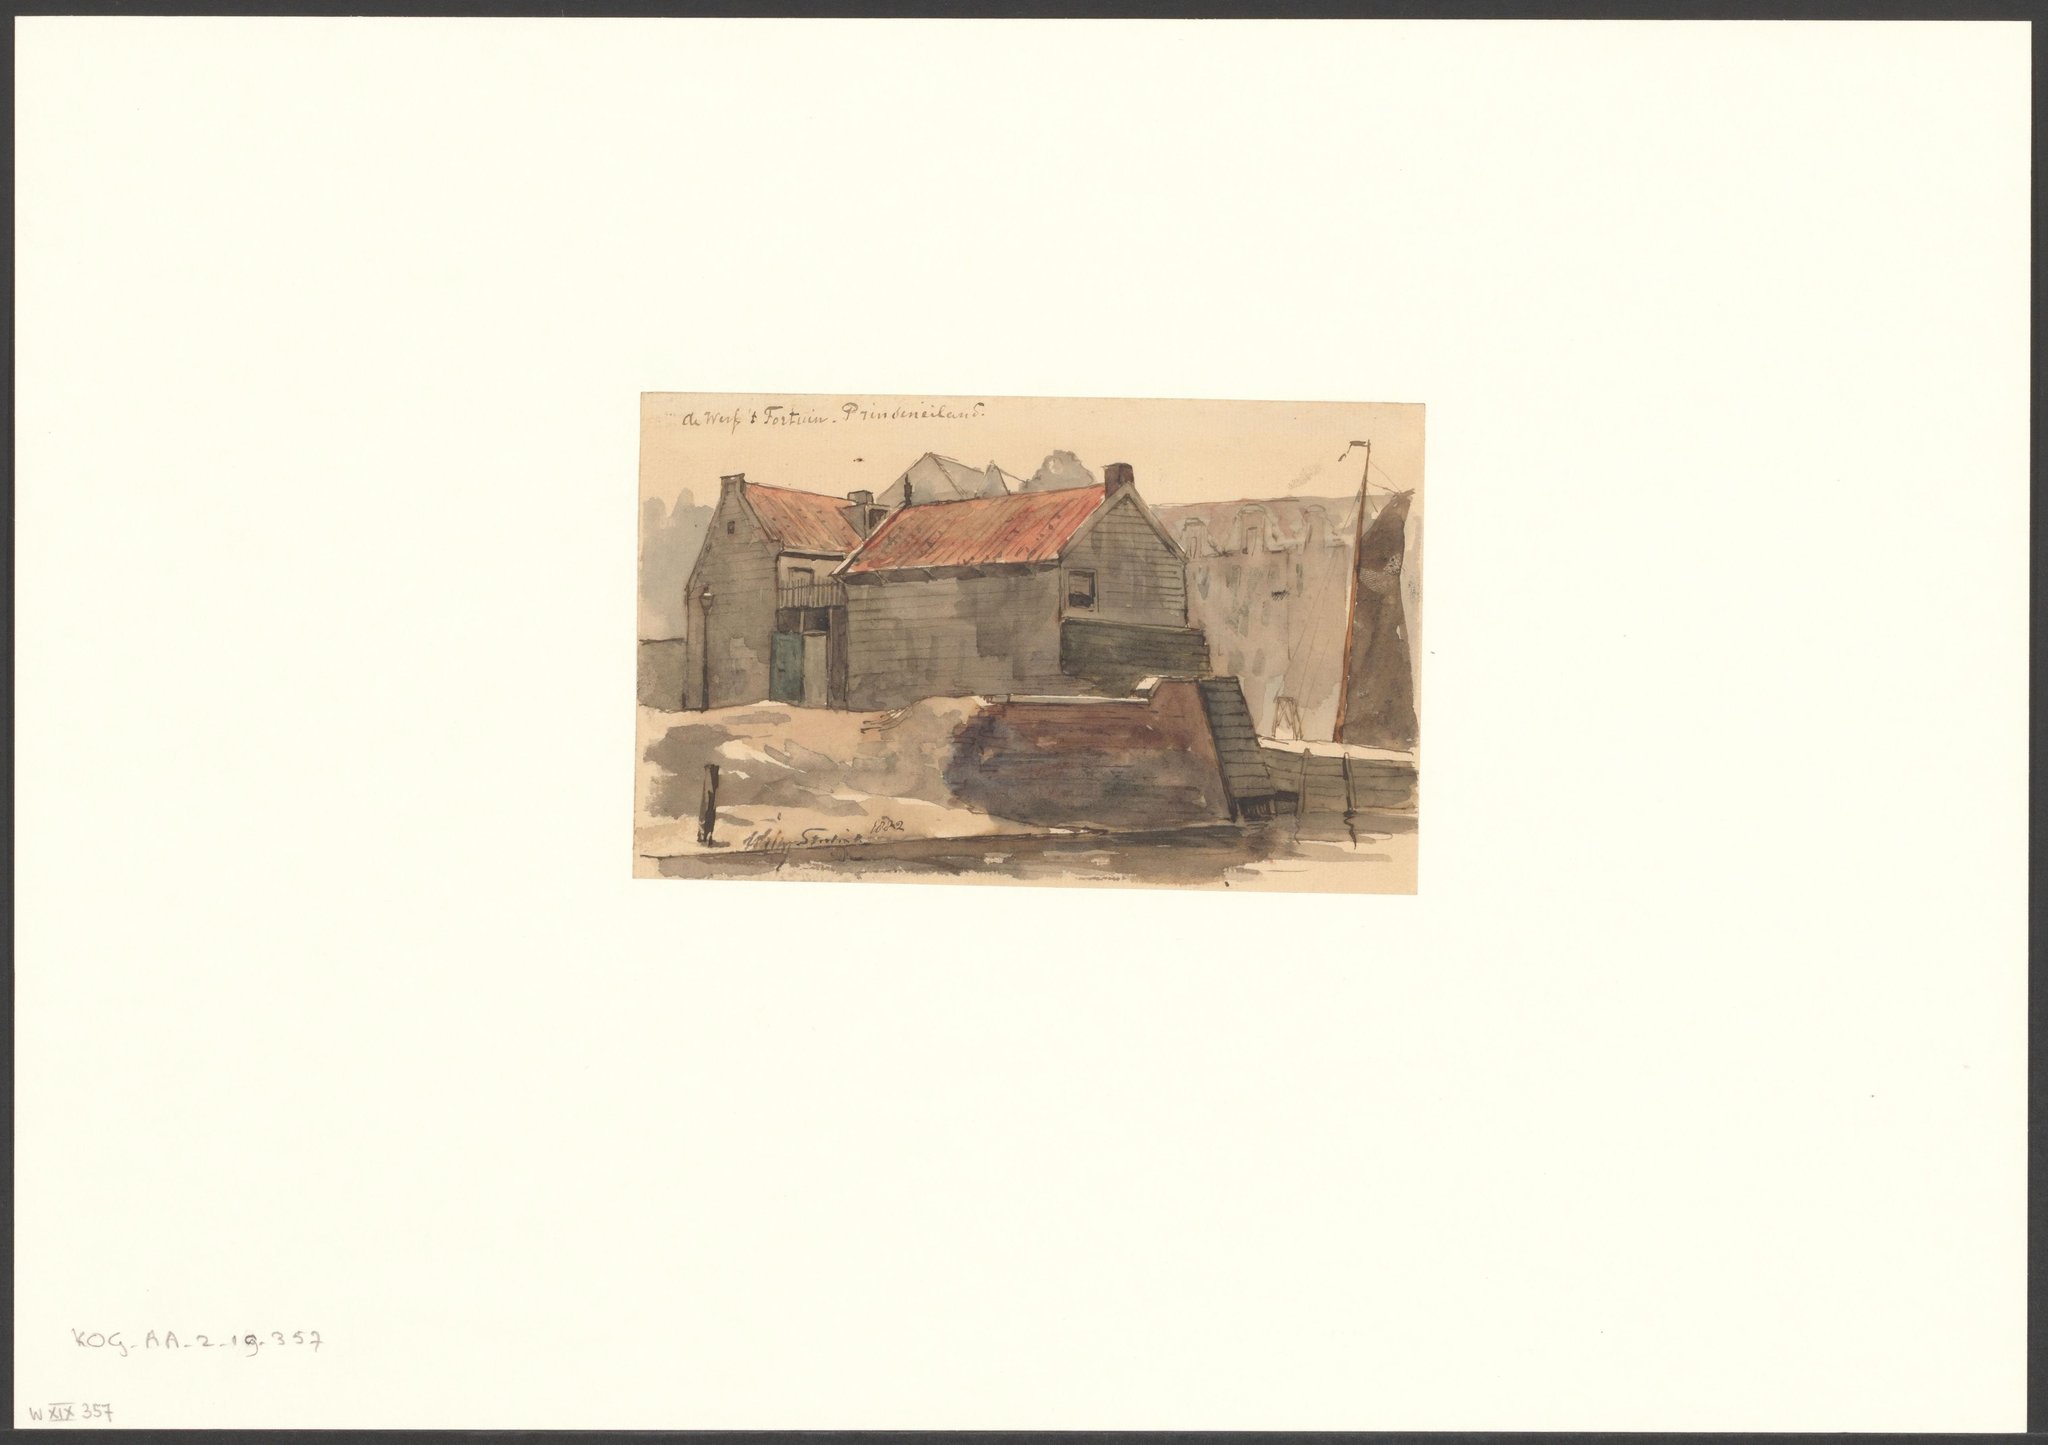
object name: drawing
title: Gezicht op de werf 't Fortuin op het Prinseneiland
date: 1882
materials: ink, paper, watercolor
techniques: brush, pen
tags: city-view in general; 'veduta', pier, quay, wharf, façade (of house or building)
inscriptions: signature and date: ‘WillemSteelink 1882’, inscription: ‘de Werf 't Fortuin Prinseneiland.’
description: Tekening binnen de Atlas Van Eck ingedeeld op wijknummer 19.